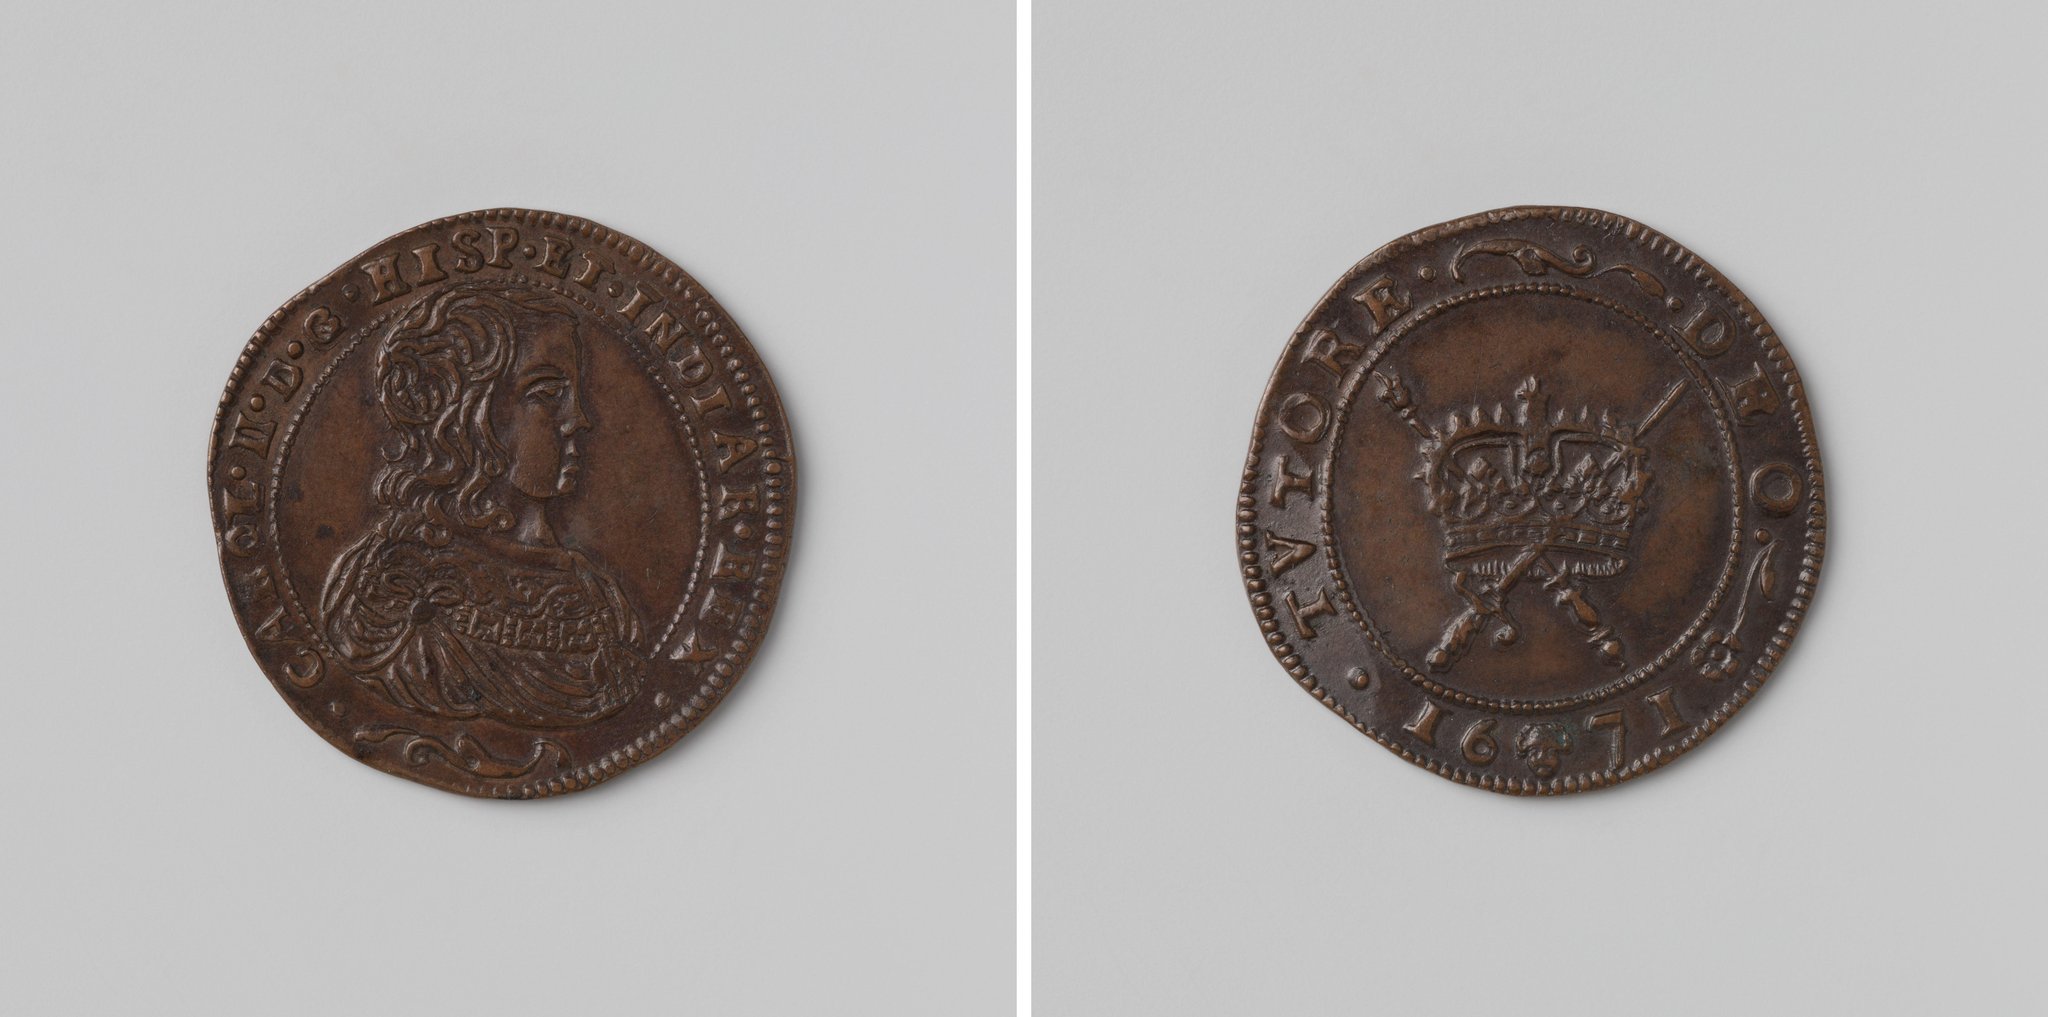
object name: jeton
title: Karel II, koning van Spanje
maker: Anonymous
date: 1671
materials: copper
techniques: striking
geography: brussels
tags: karel ii (koning van spanje)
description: Koperen penning. Voorzijde: borststuk man binnen omschrift. Keerzijde: kroon waar gekruist zwaard en scepter doorheen steken binnen omschrift